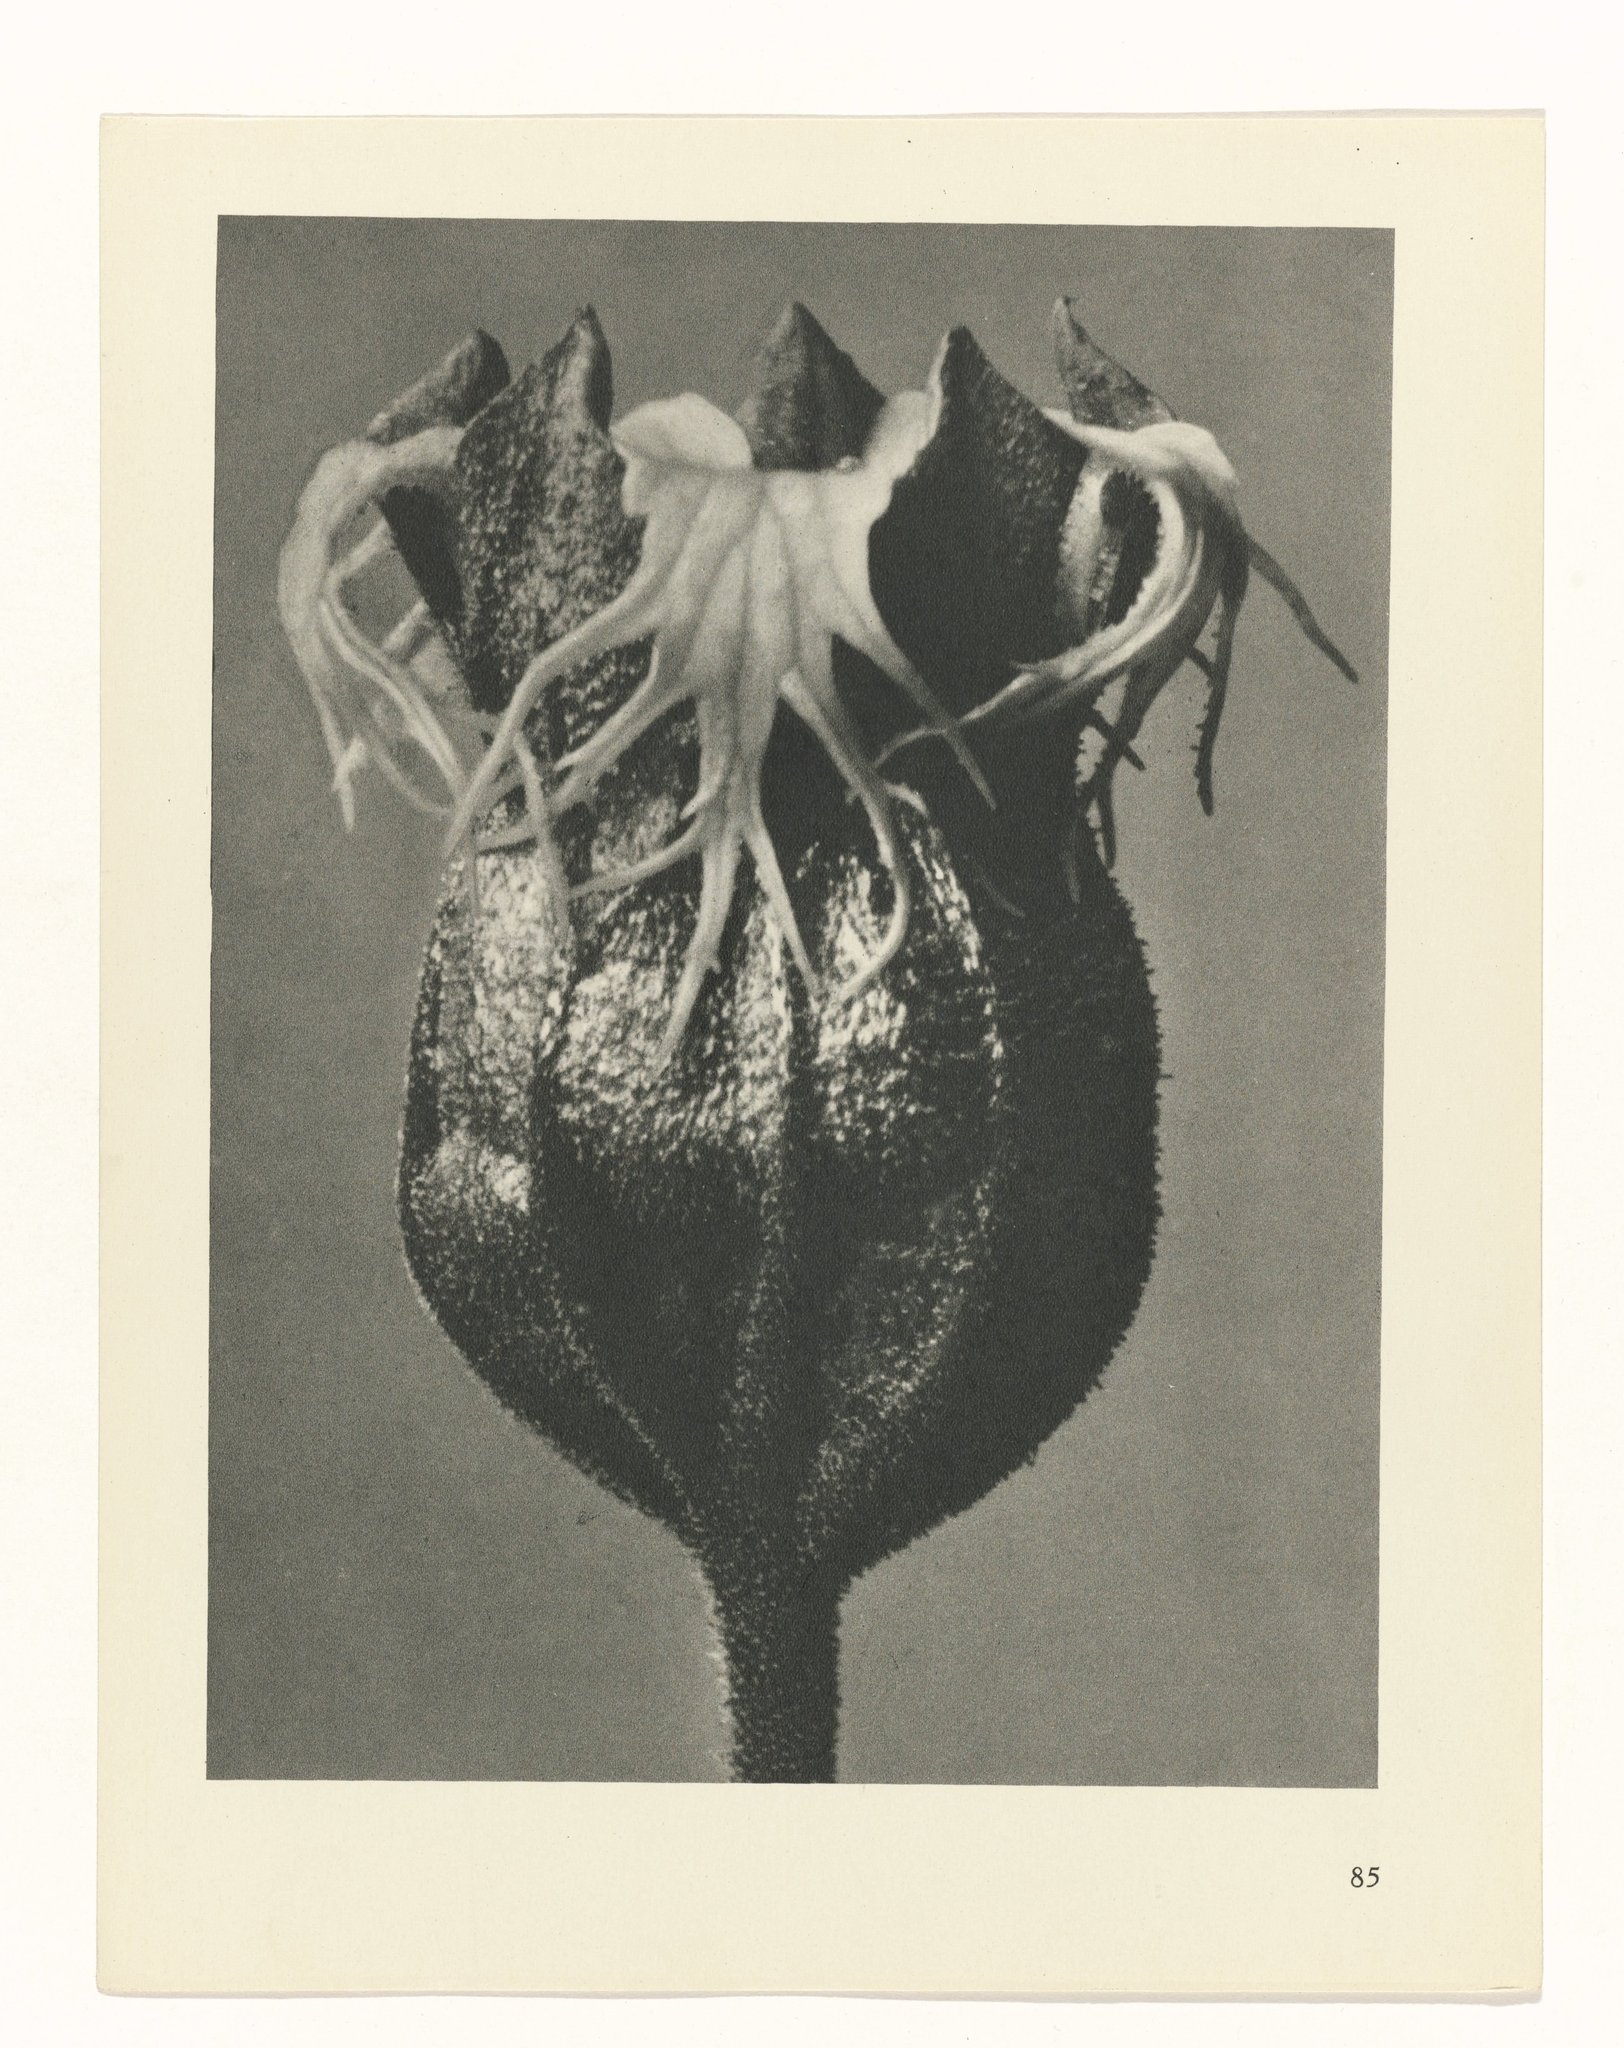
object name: photograph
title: Plantstudie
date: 1928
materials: ink, paper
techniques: rotogravure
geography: berlin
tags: plants (in general)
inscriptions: number: ‘85’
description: facher Vergrößerung. Afkomstig uit losbladige uitgave.